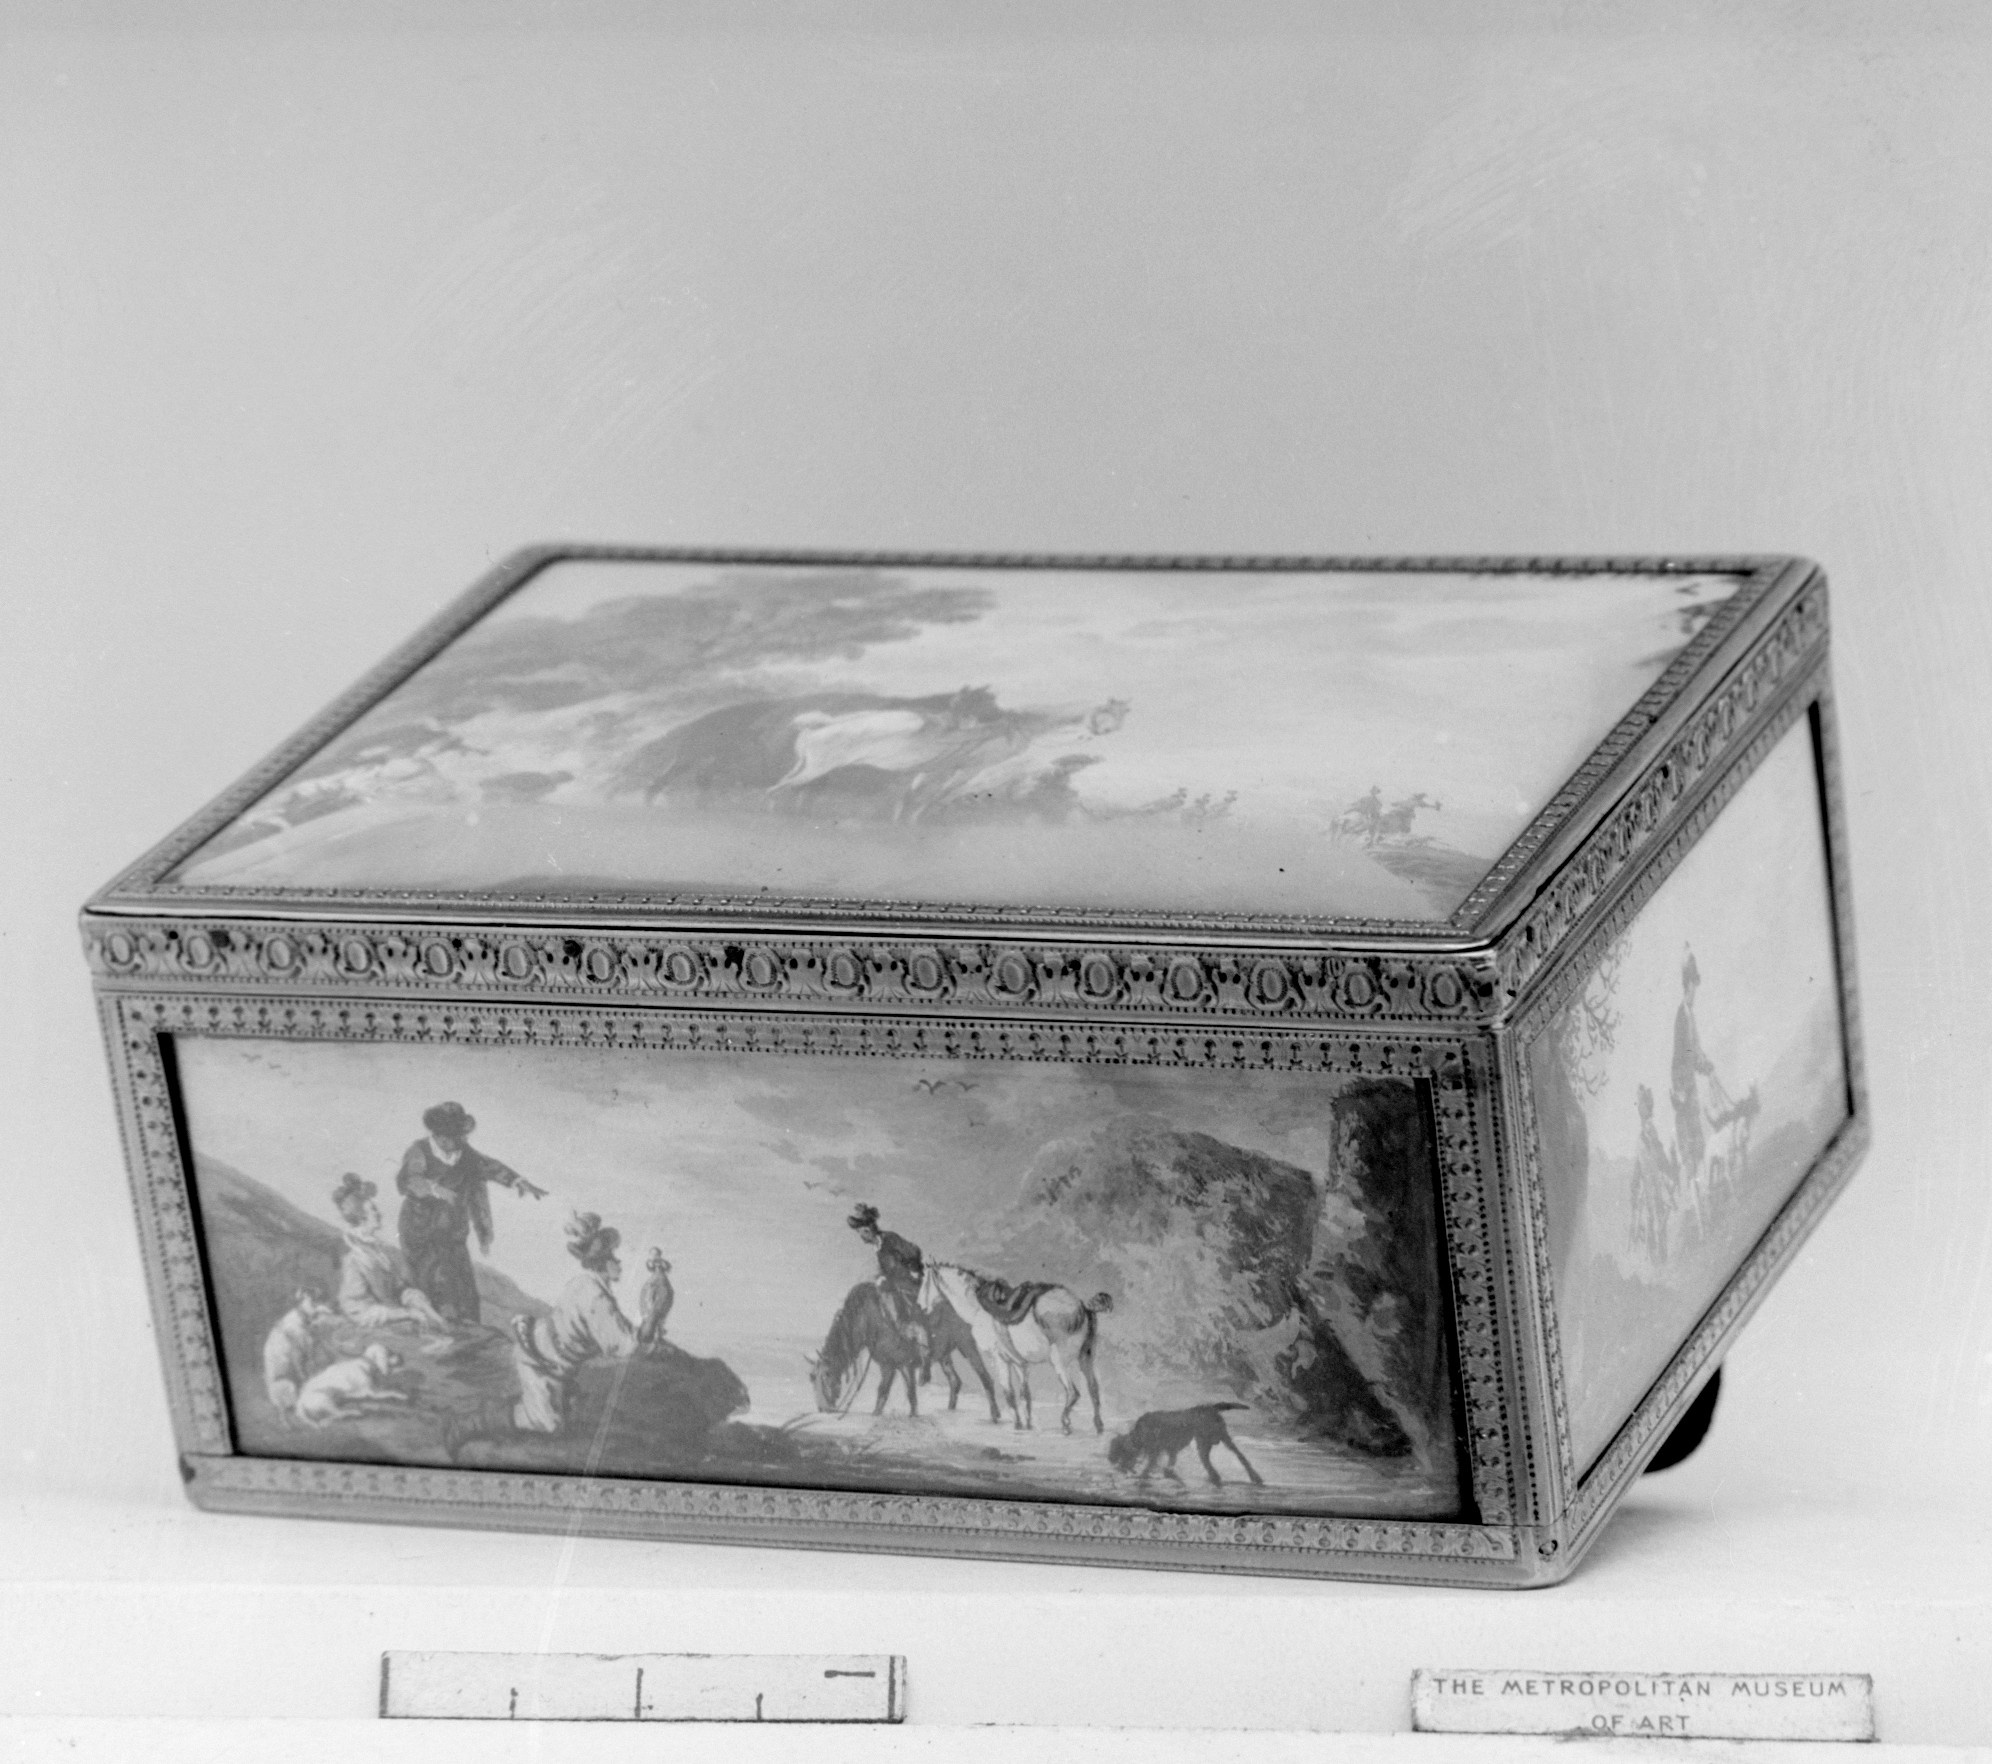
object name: snuffbox, painting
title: Snuffbox with hunting scenes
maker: j.d.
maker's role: maker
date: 1768-1769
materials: gold, paper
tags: animals,hunting,horses